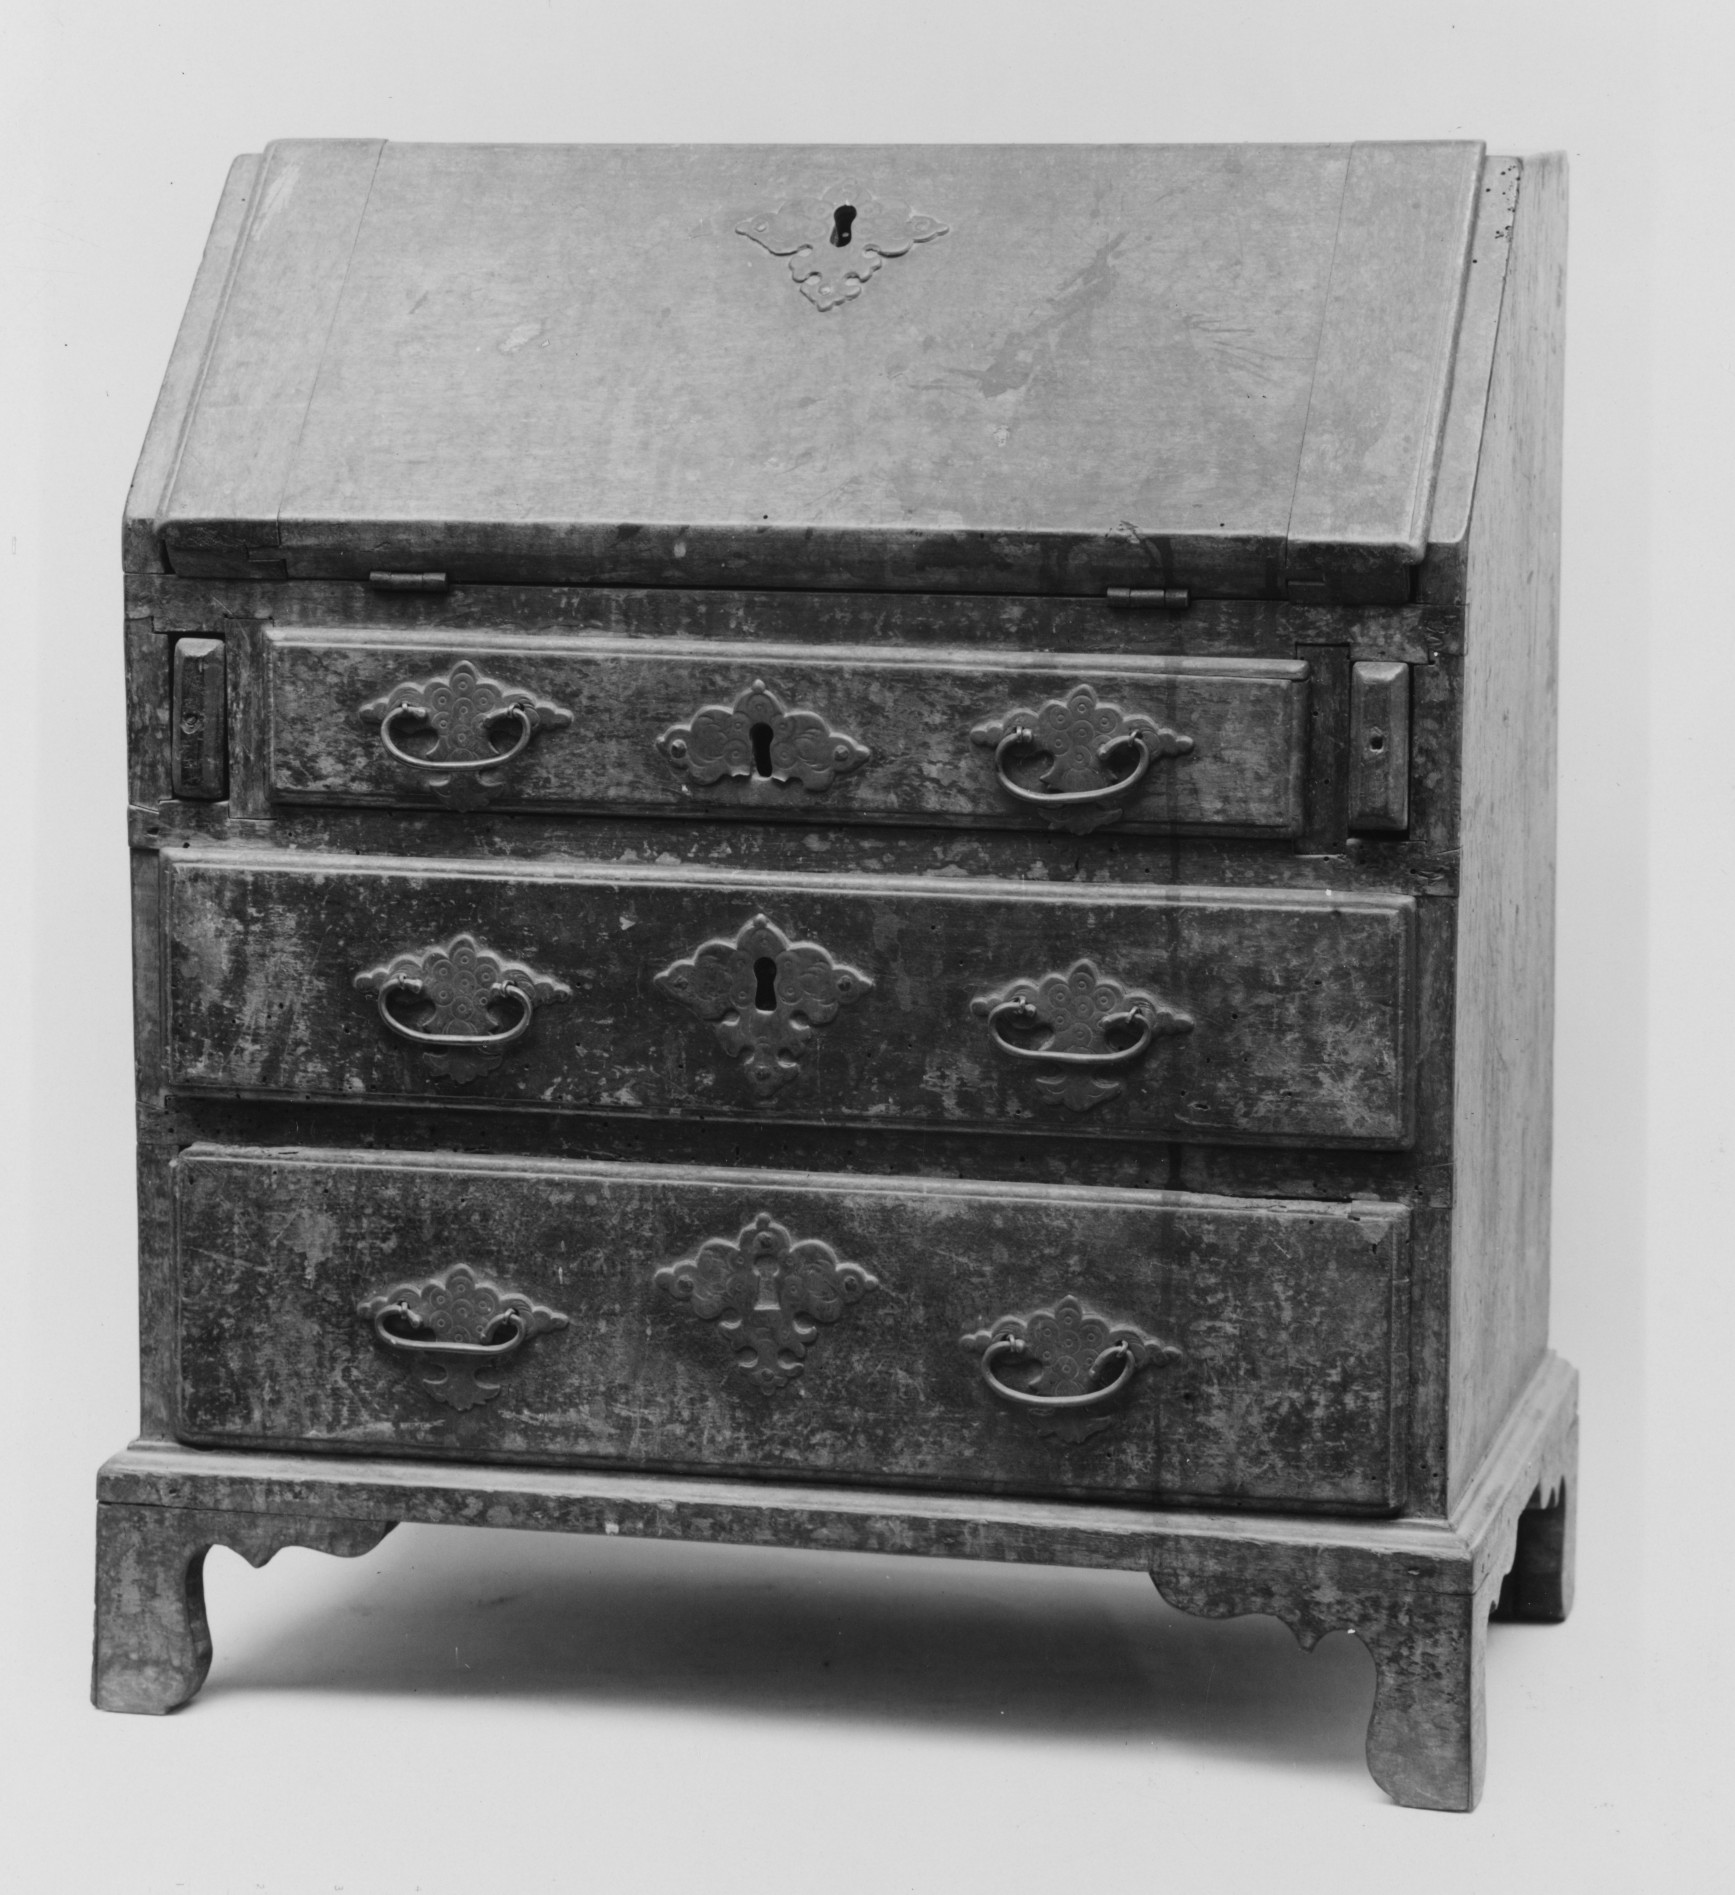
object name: desk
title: Child's Desk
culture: american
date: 1725-1760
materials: wood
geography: united states